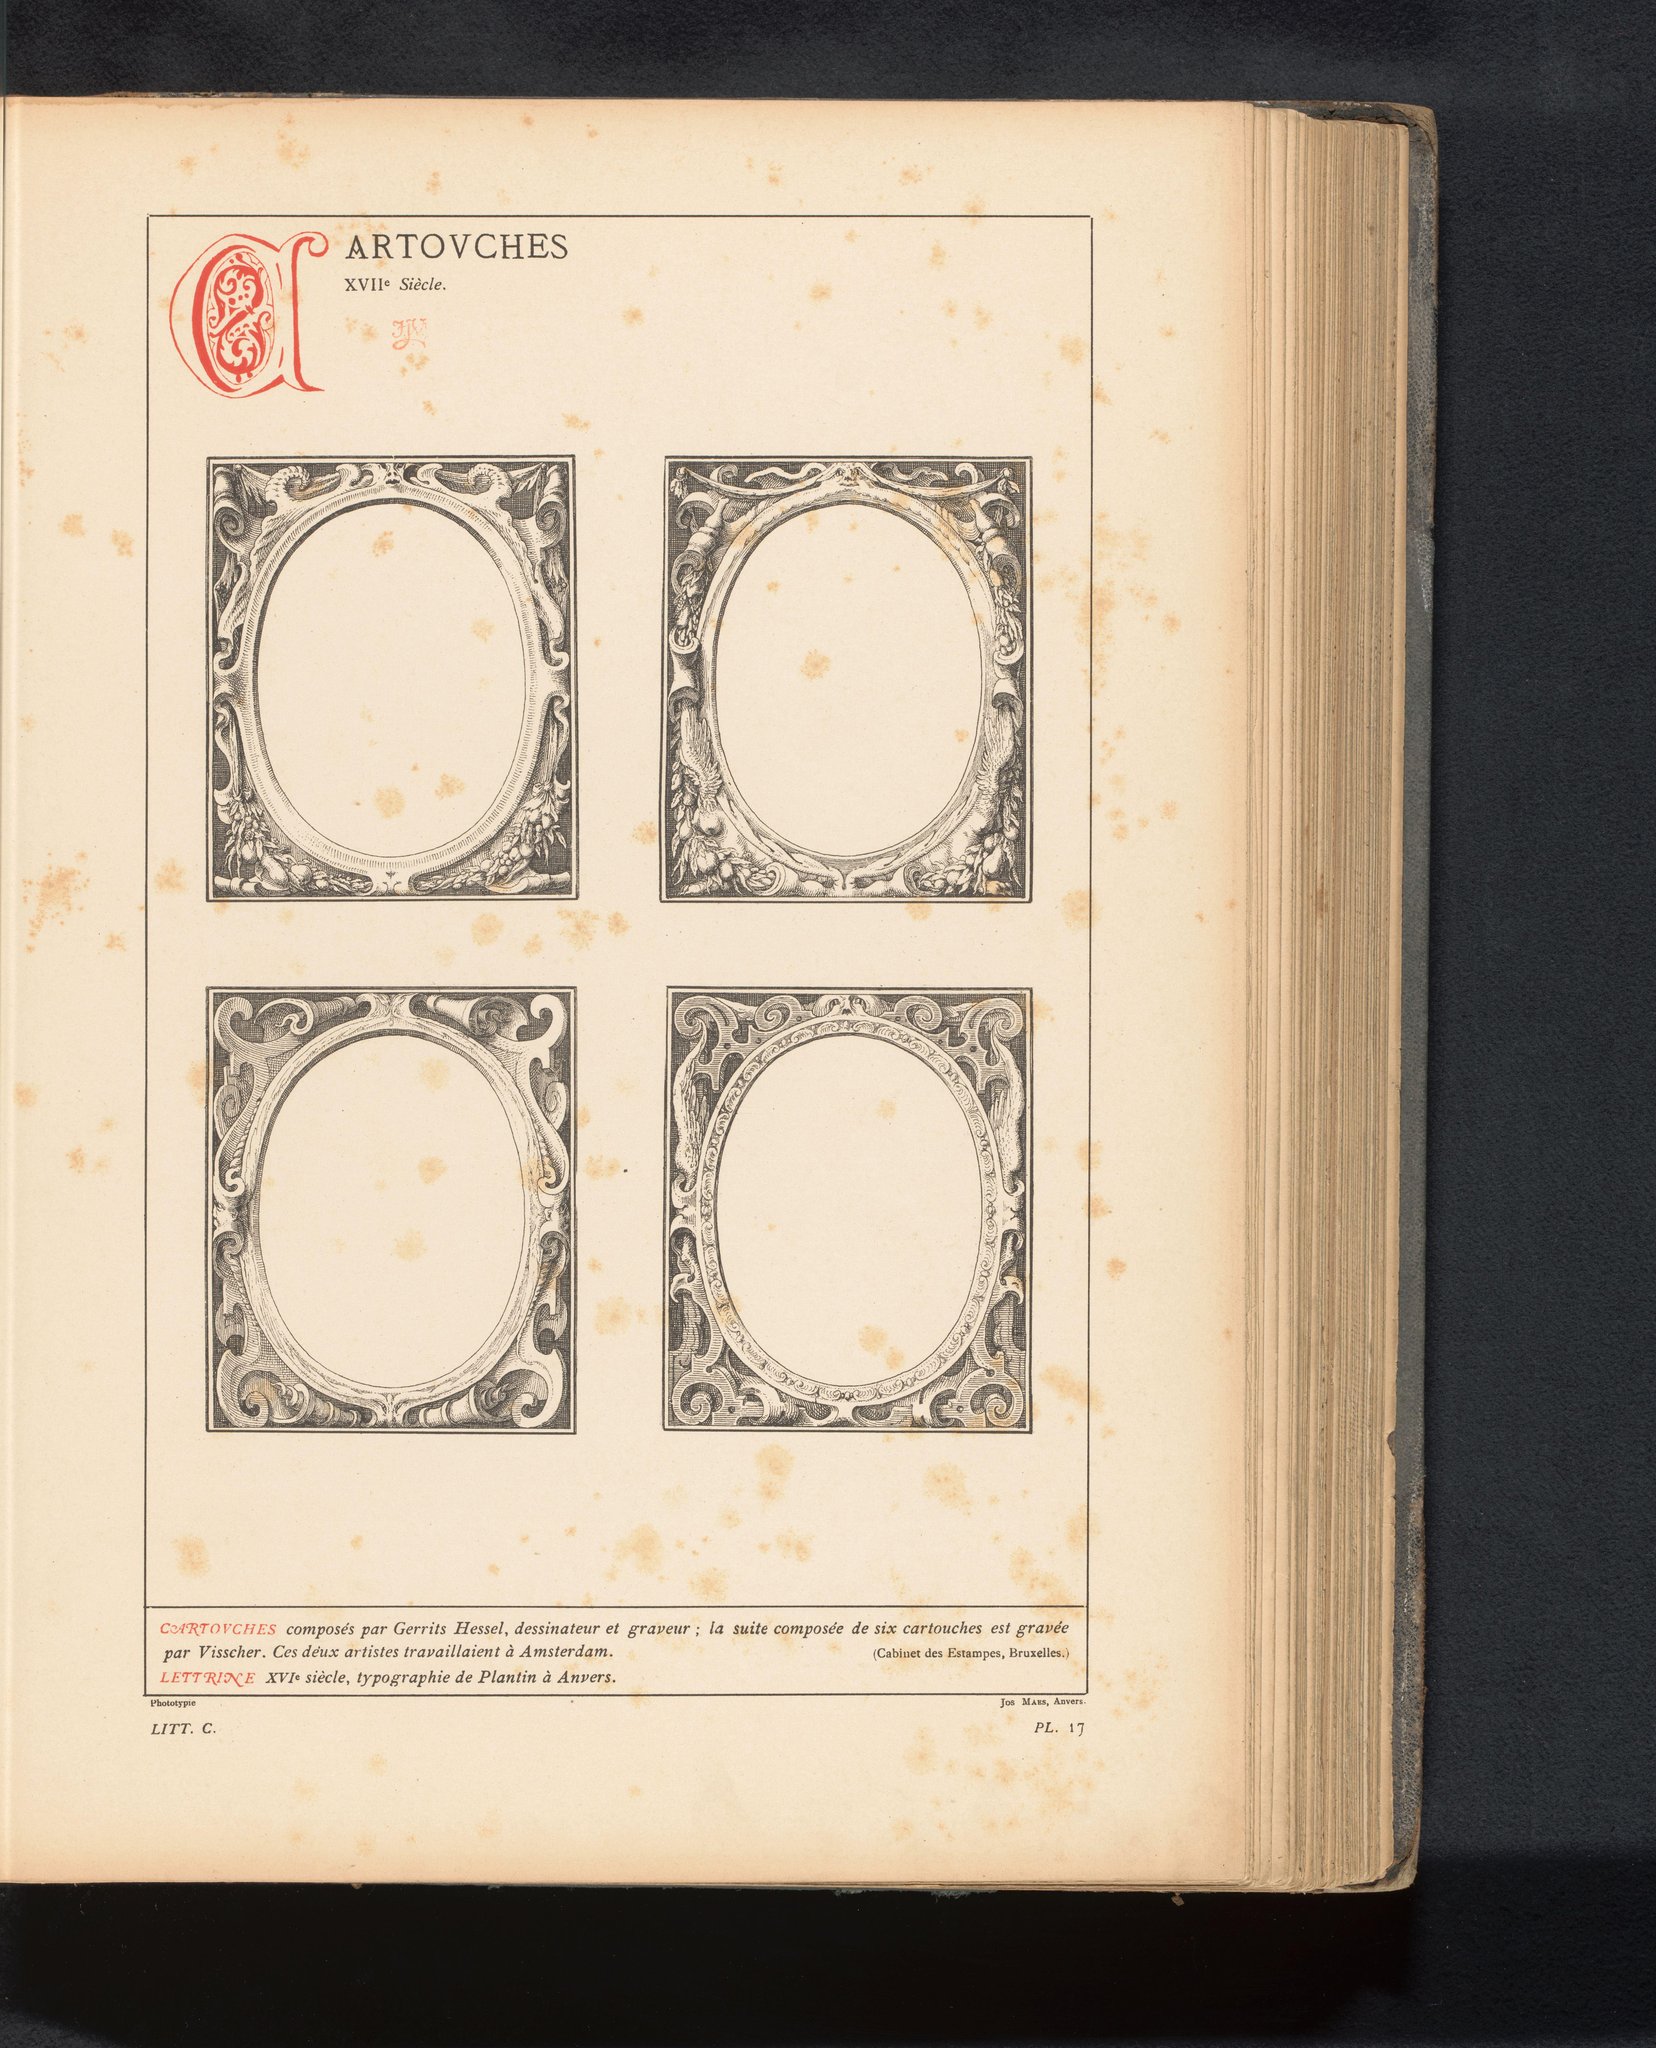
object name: photomechanical print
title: Reproductie van een prent met vier cartouches door Hessel Gerritsz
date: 1875-1880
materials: paper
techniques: photolithography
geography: antwerp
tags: ornament ~ cartouche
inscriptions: inscription: ‘Cartouches composés par (...)’, inscription: ‘LITT: C. - PL. 17’, monogram: ‘JJvY’